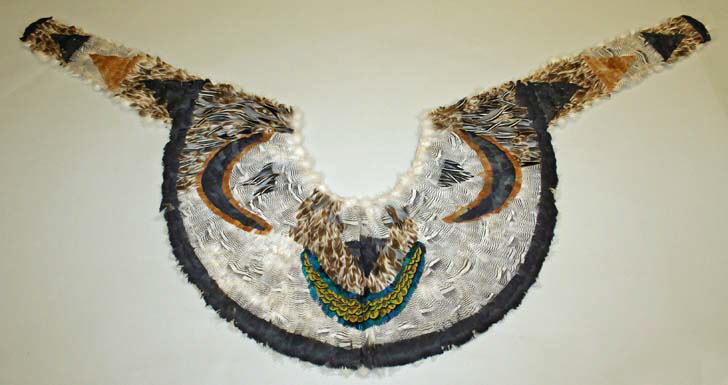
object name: cape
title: Shoulder Cape (Pelerine)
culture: native american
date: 1830-1850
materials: cotton, feather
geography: united states